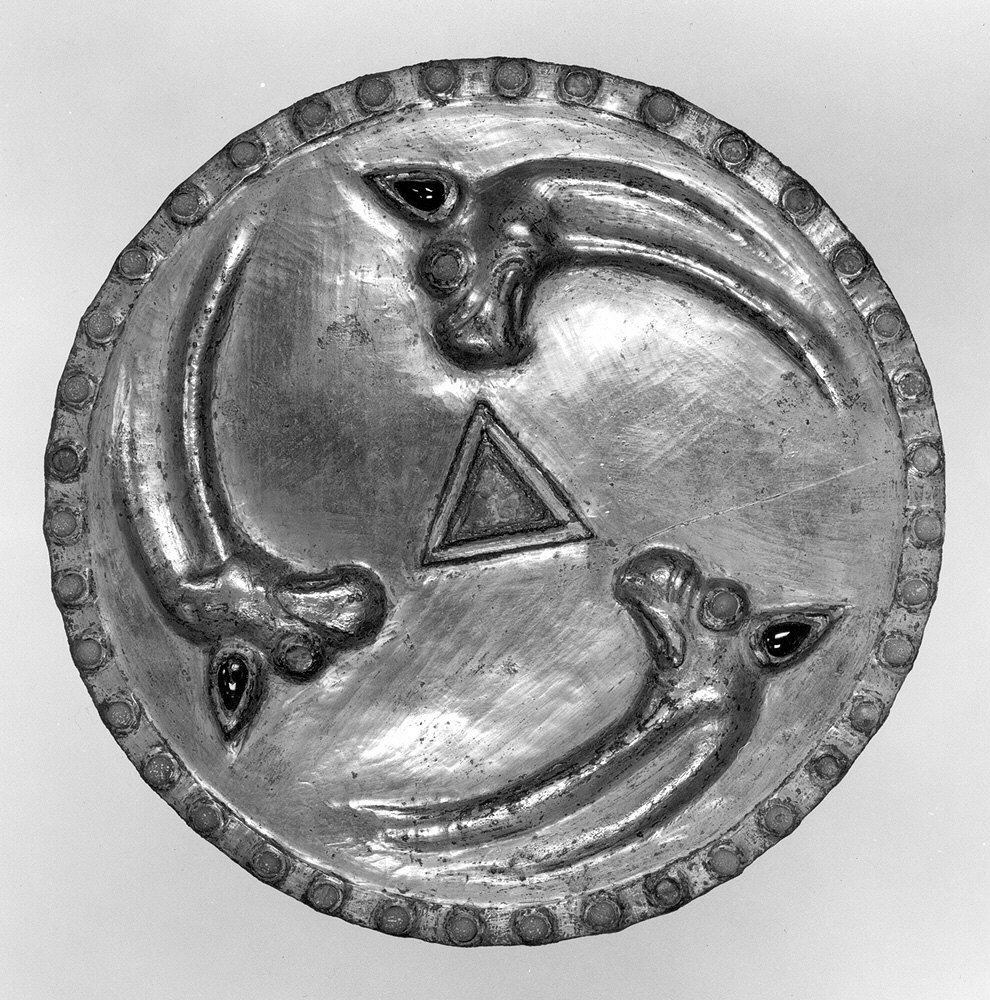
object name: roundel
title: Roundel with griffin heads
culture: sarmatian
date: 1-200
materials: silver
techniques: gilding, inlay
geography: eurasian steppes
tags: griffins